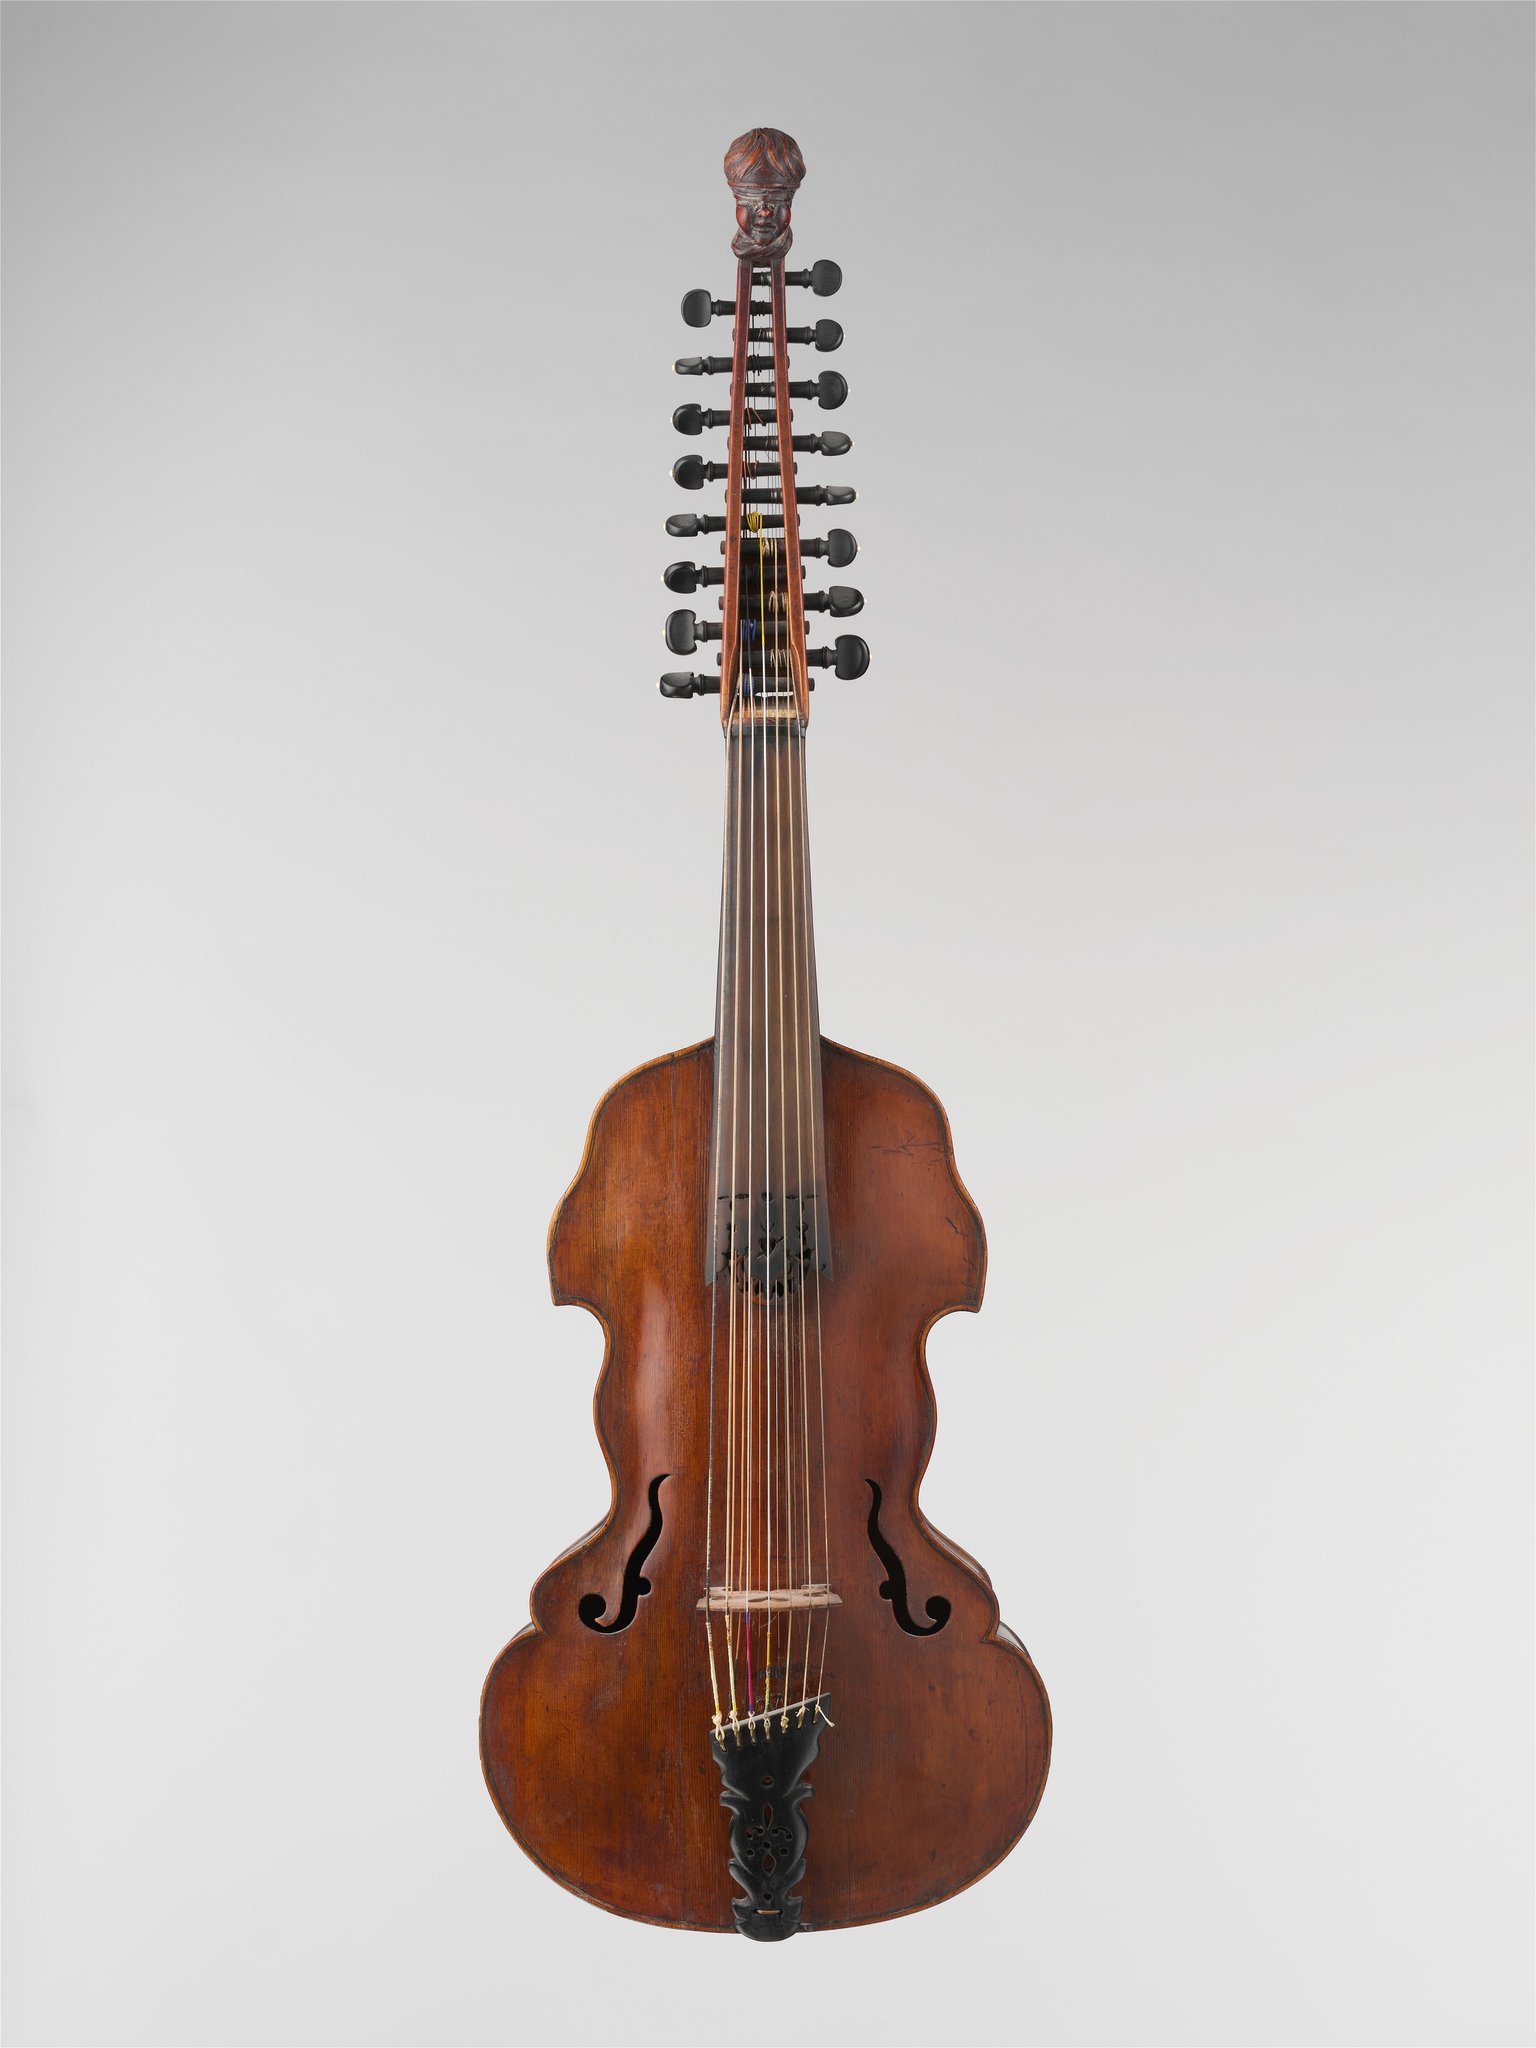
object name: english violet viola d'amore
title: English violet (Viola d'Amore)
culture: german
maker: paulus alletsee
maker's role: maker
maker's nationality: german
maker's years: 1698-1738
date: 1726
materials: wood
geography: germany